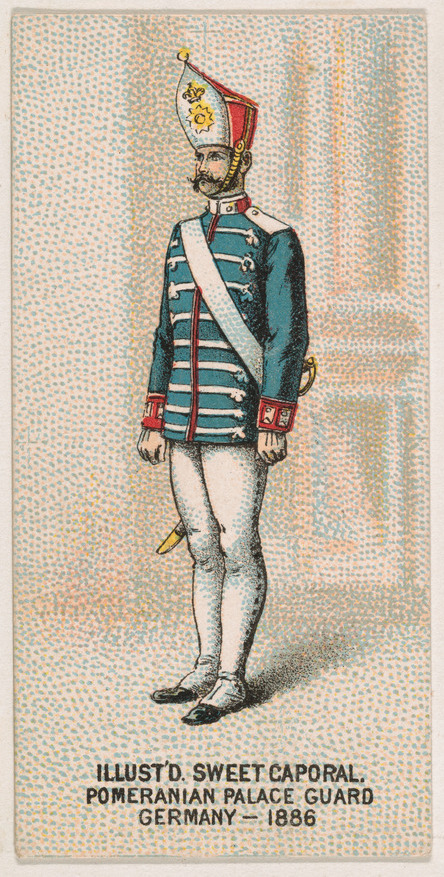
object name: print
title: Pomeranian Palace Guard, Germany, 1886, from the Military Series (N224) issued by Kinney Tobacco Company to promote Sweet Caporal Cigarettes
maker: kinney brothers tobacco company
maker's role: publisher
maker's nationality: american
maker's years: 1869-2011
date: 1888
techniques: color lithograph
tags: military,men